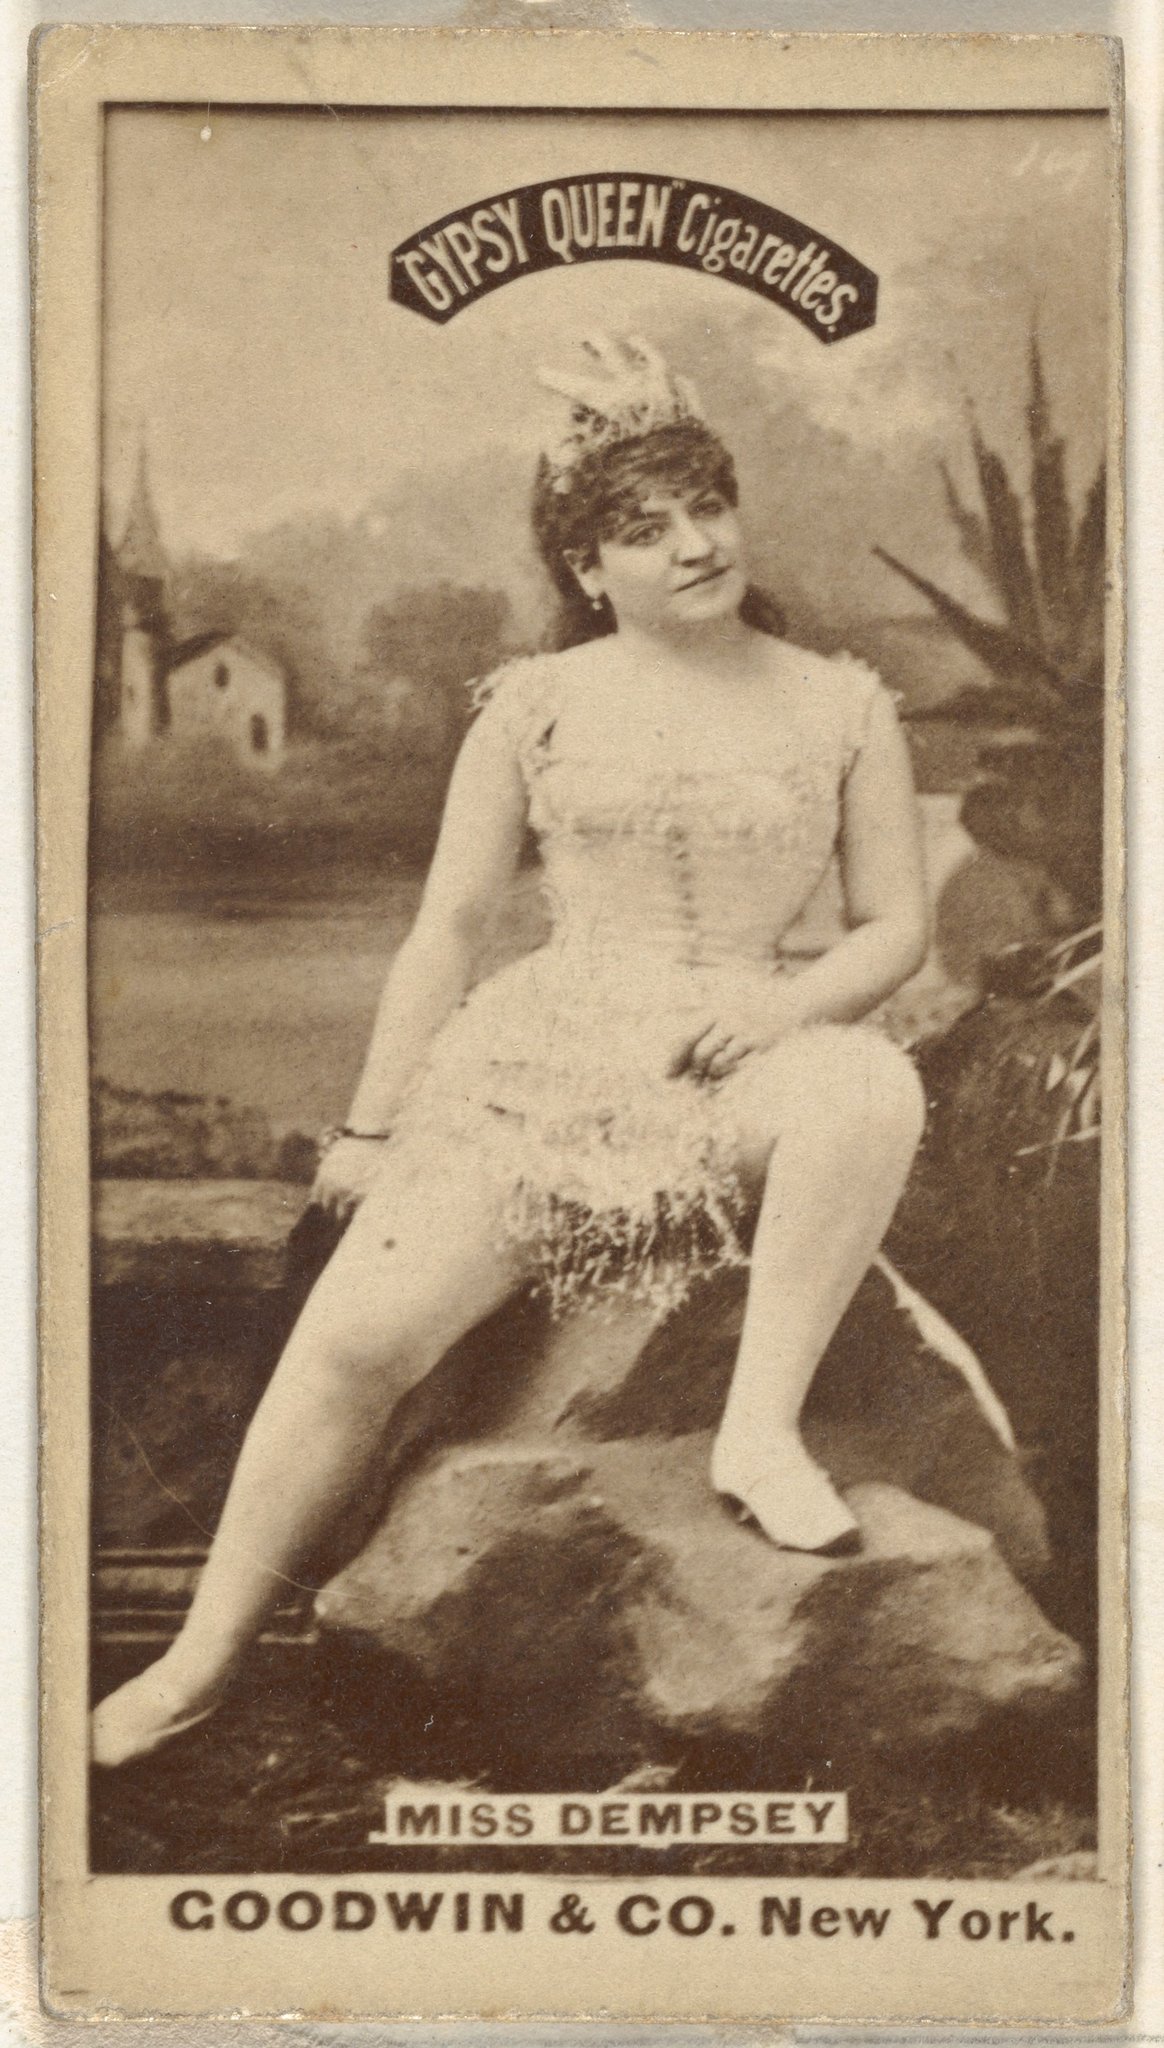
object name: photograph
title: Miss Dempsey, from the Actors and Actresses series (N171) for Gypsy Queen Cigarettes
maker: goodwin & company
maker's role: publisher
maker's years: 1850-1950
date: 1886-1890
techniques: albumen silver print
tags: portraits,women,actresses